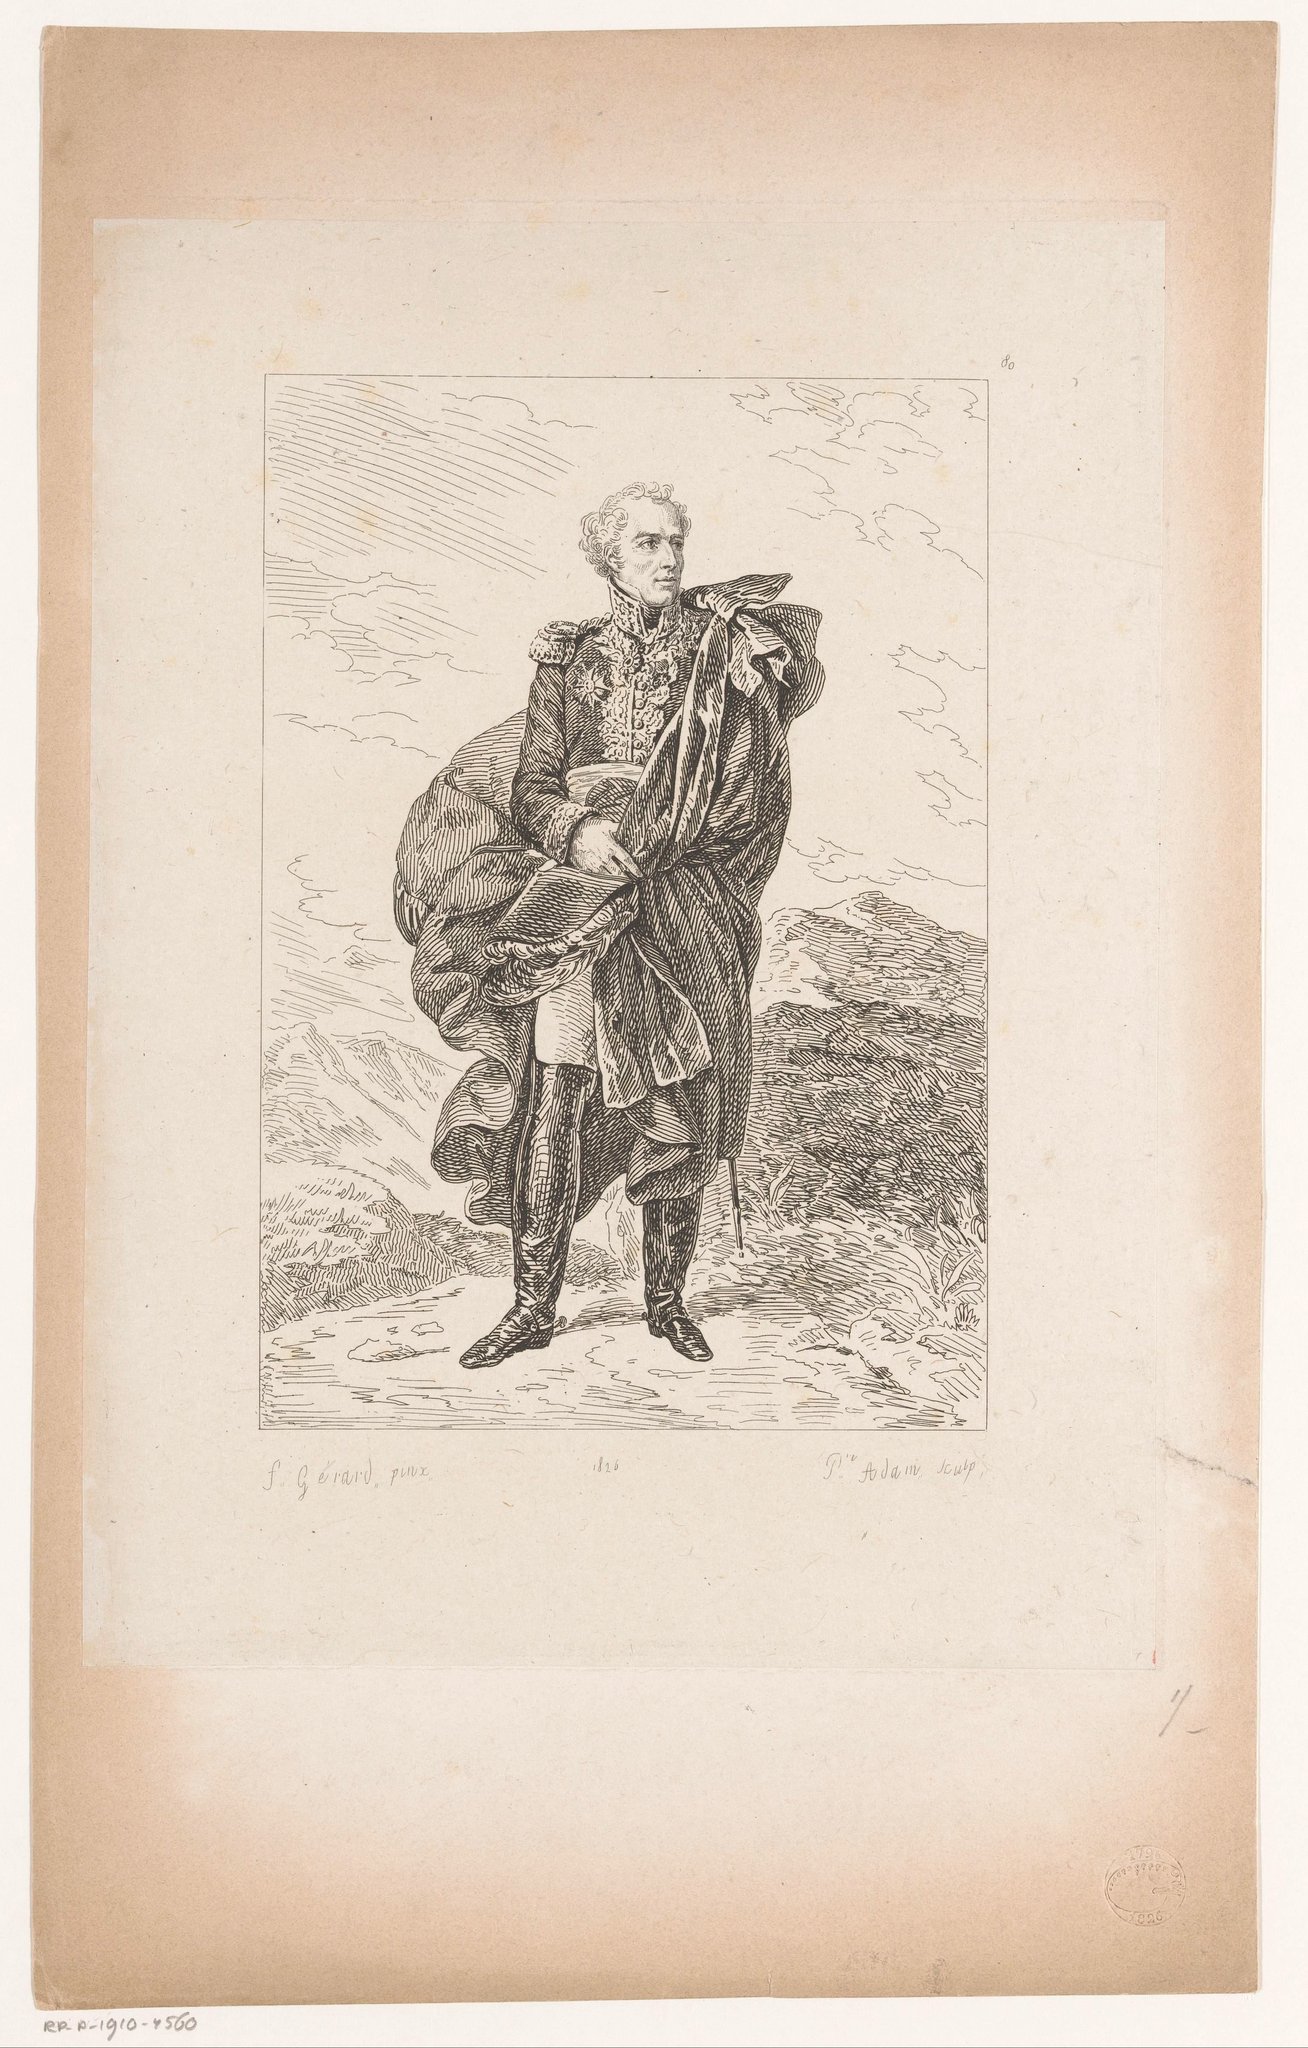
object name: print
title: Collectie van historische portretten van Baron Gérard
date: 1826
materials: paper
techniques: etching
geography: paris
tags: politician, maximilien sébastien foy, historical persons, (military) uniforms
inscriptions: check stamp: ‘1796 / 1826’, collector's mark: Lugt 2228, inscription: ‘Le General Comte Foy’